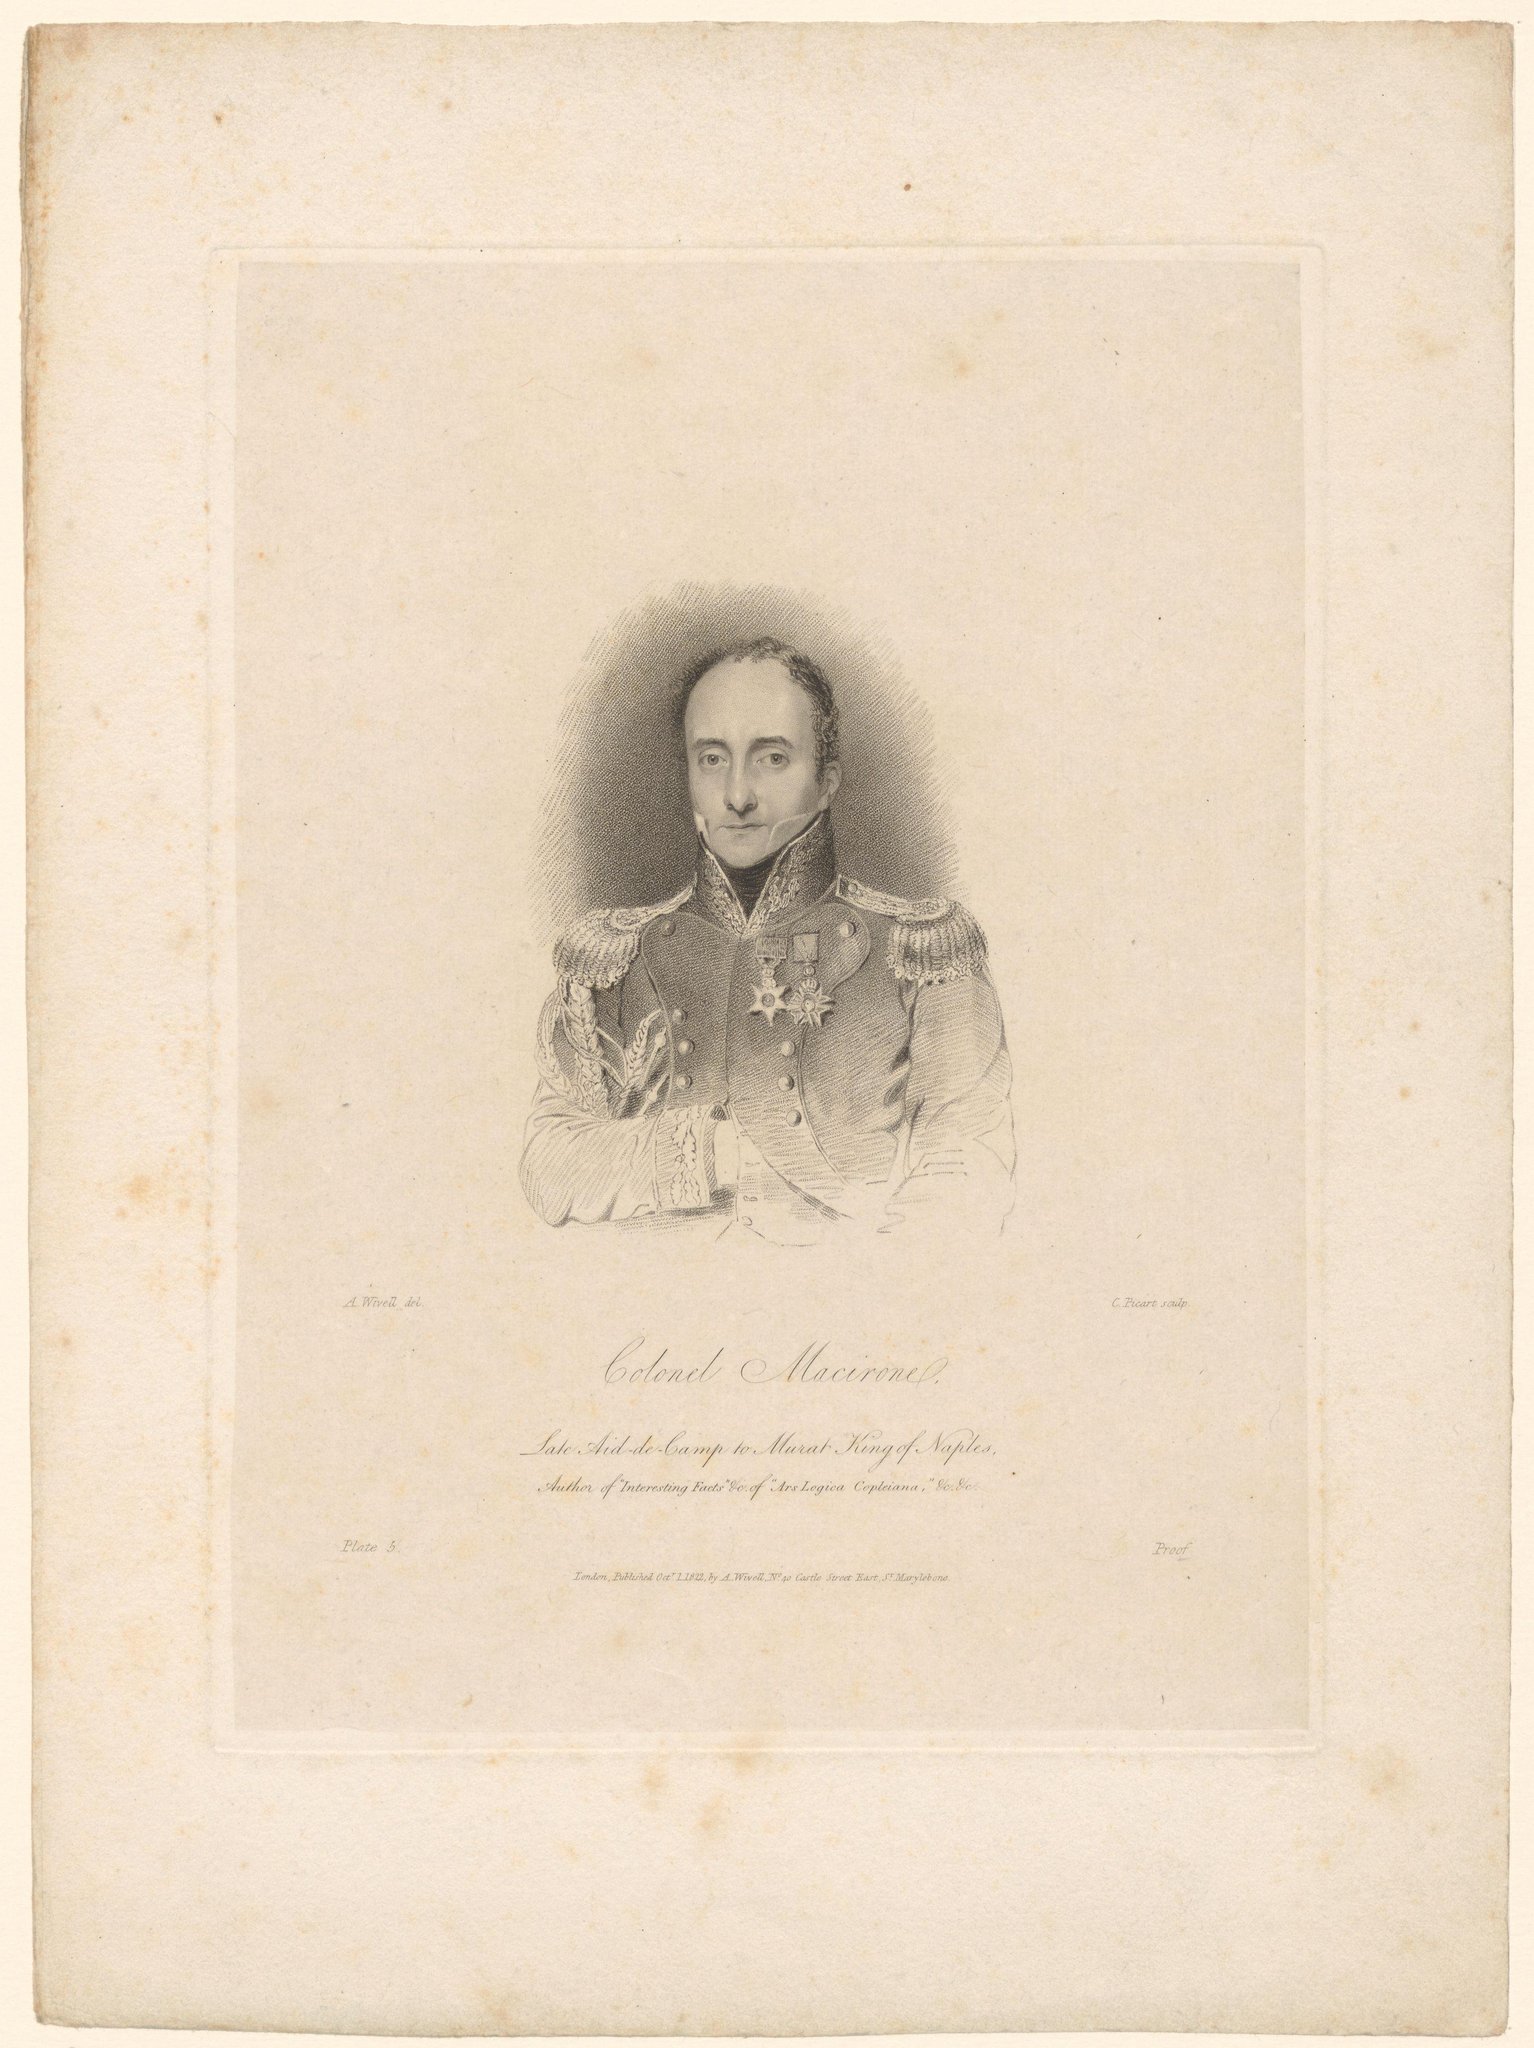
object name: print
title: Colonel Macirone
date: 1822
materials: paper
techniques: etching, roulette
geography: england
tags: engineering (+ portrait of scholar, scientist), historical persons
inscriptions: collector's mark: Lugt 2228